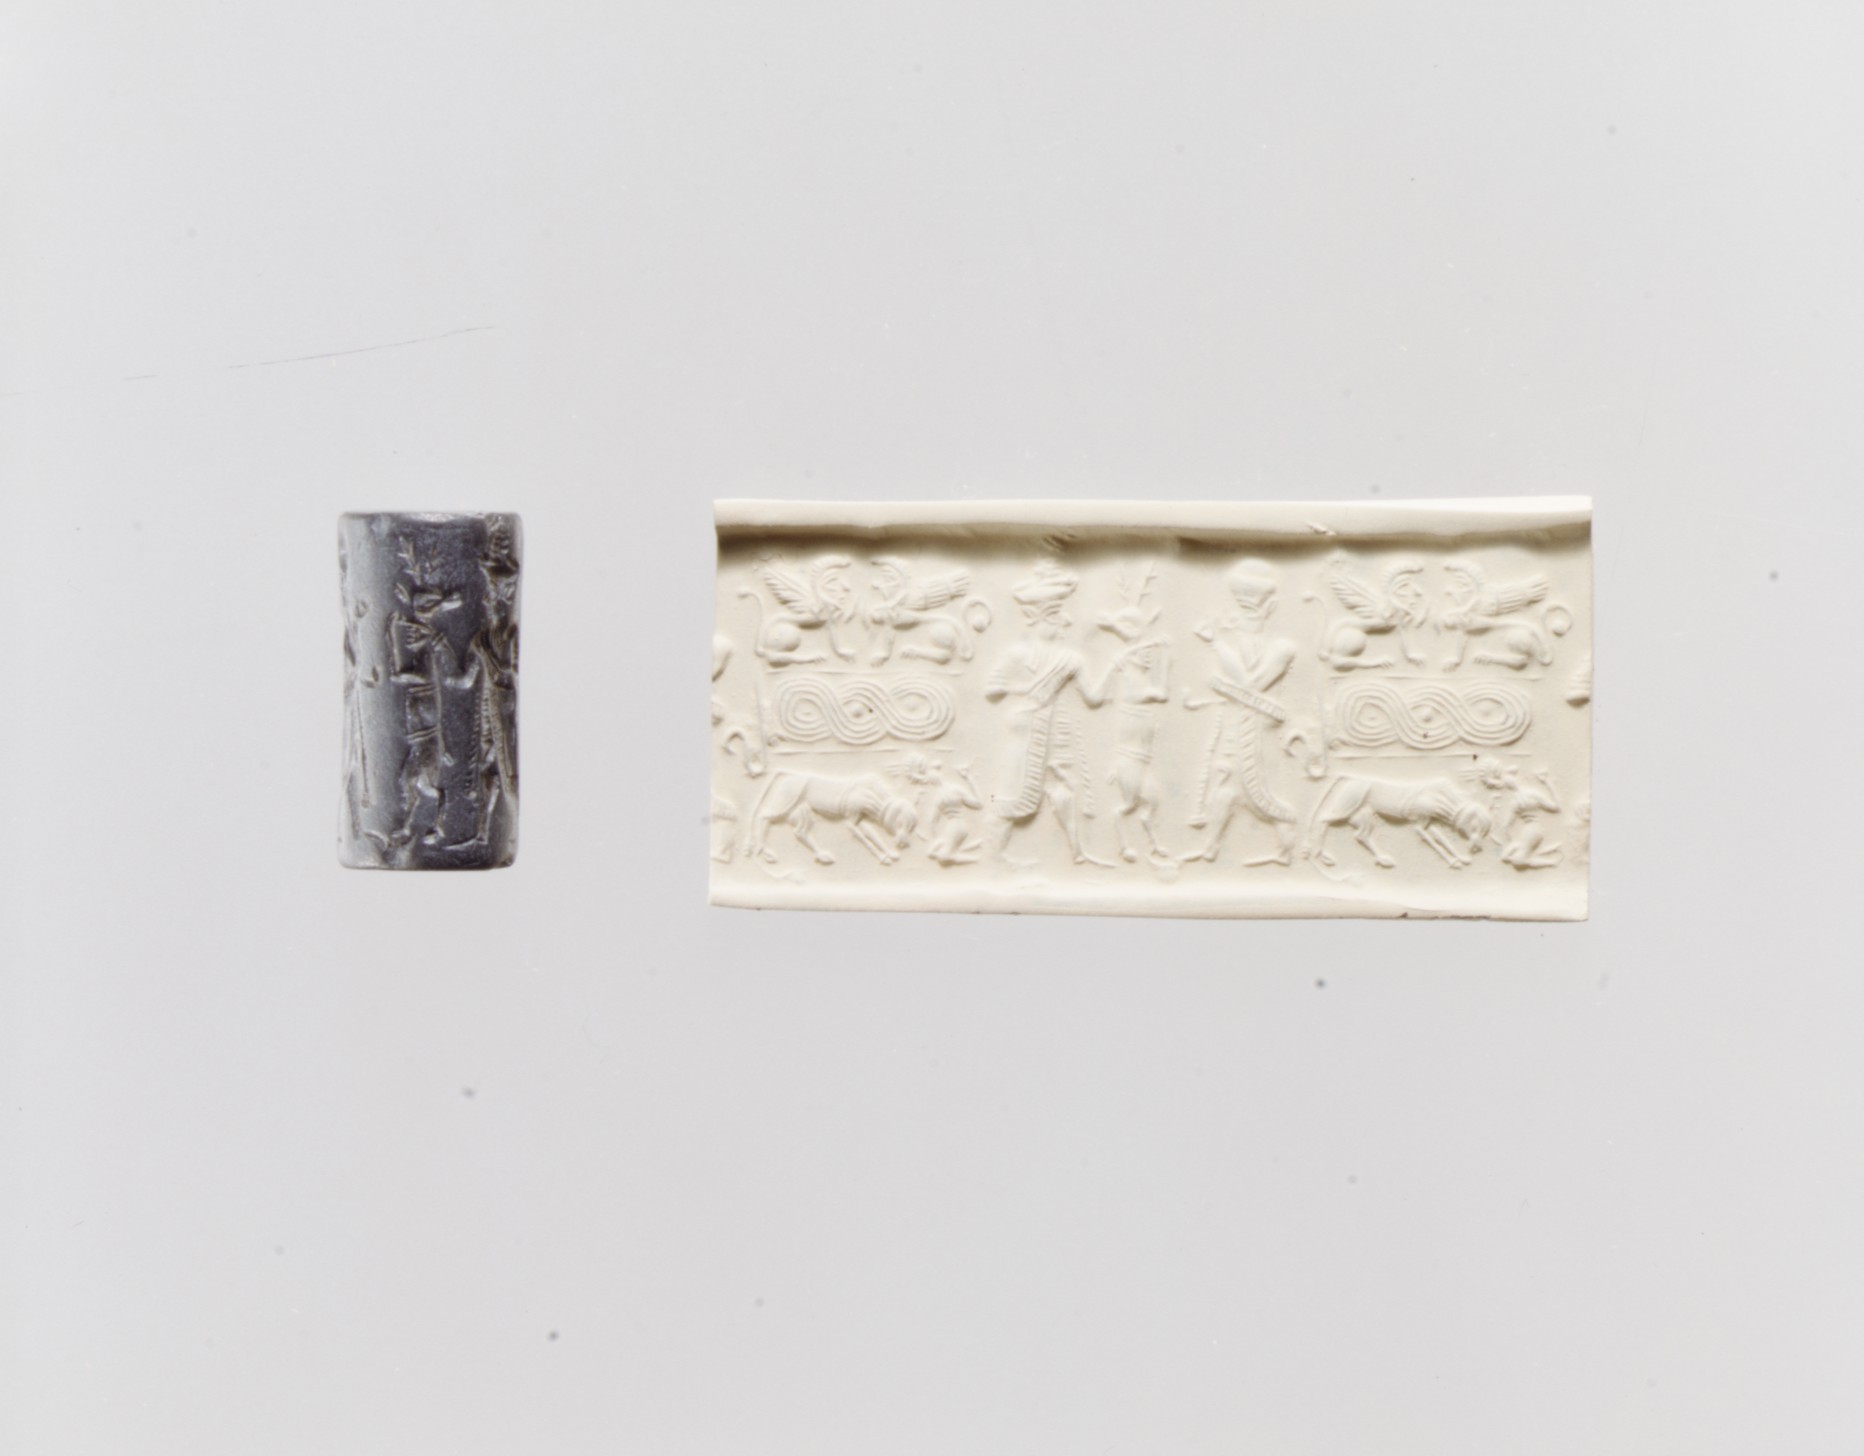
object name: cylinder seal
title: Cylinder seal and modern impression: deity, goat, and worshiper; terminal; sphinxes, guilloche, bull and leaper (?)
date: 1820-1730 BCE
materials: mineral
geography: syria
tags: sphinx,bulls,goats